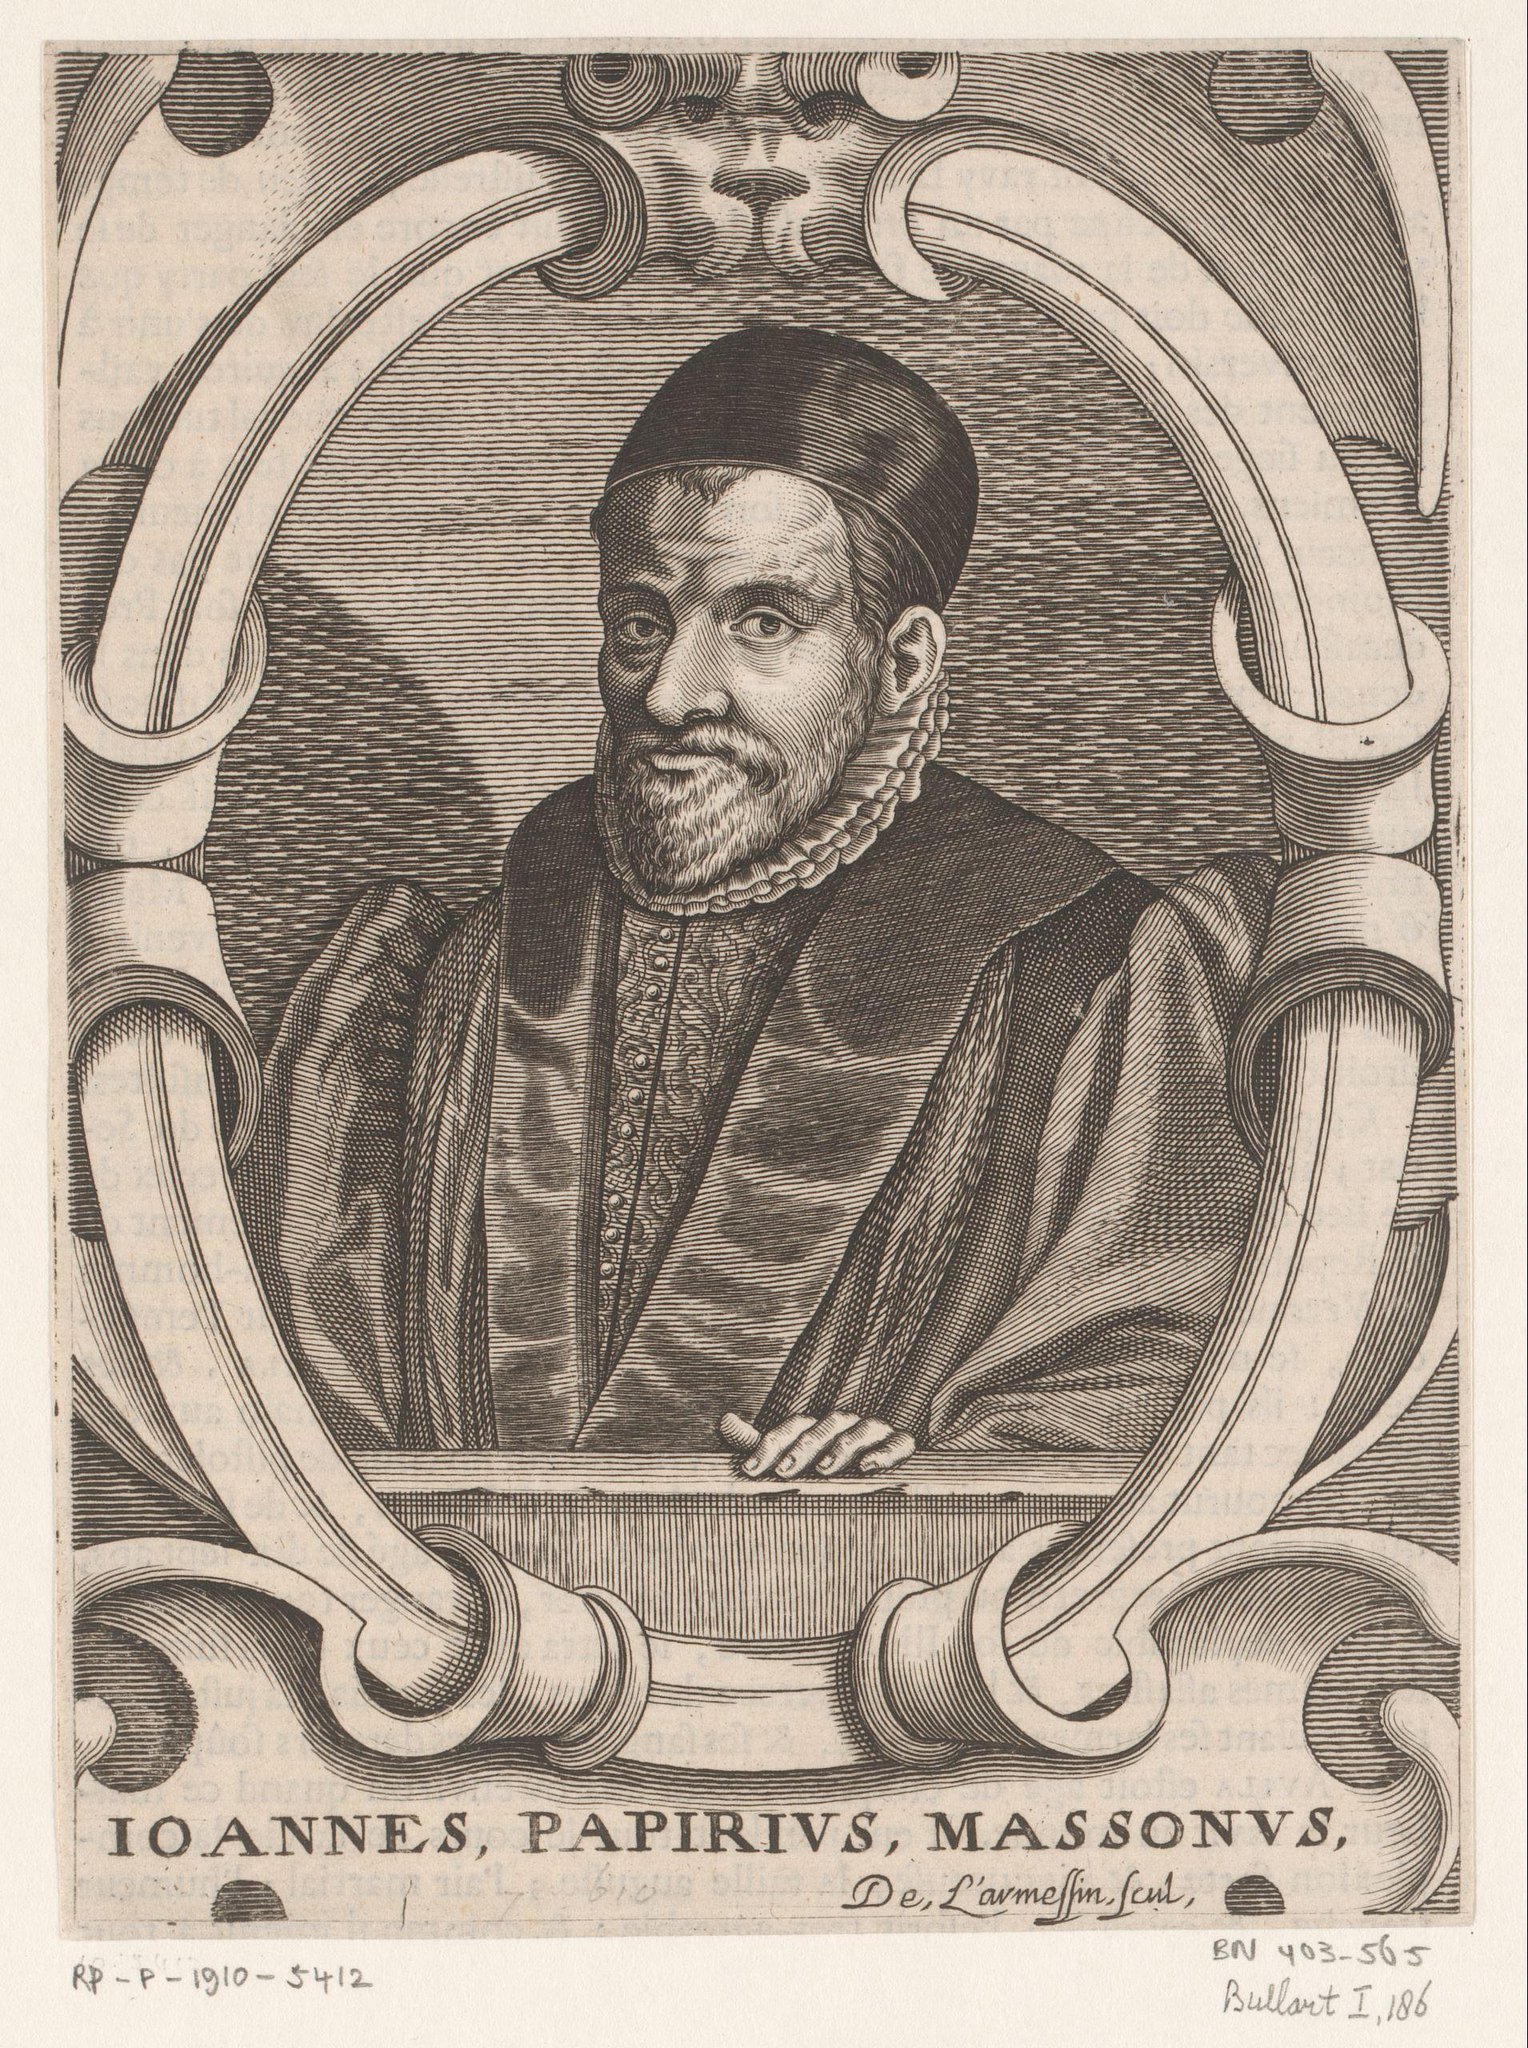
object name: book illustration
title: Portret van Jean Papire Masson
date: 1682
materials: paper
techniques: engraving, letterpress printing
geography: brussels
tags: historical persons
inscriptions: collector's mark: Lugt 2228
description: Prent gebruikt voor: Bullart, Isaac. Académie des Sciences et Arts contenant les vies et éloges his. des hommes illustres qui ont excellé en ces professions depuis environ quatre siècles. Brussel: François Foppens, 1682. Het boek werd in 1682 eveneens in Amsterdam uitgegeven door de erfgenamen van Daniel Elzevier. Ieder portret betreft een illustratie bij de biografie van een kunstenaar of geleerde. De meeste portretten werden door Nicolas de Larmessin vervaardigd (162), 93 door De Boulonois en een derde door ongeïdentificeerde prentmakers. Dit betreft een illustratie op p. 186, deel I.